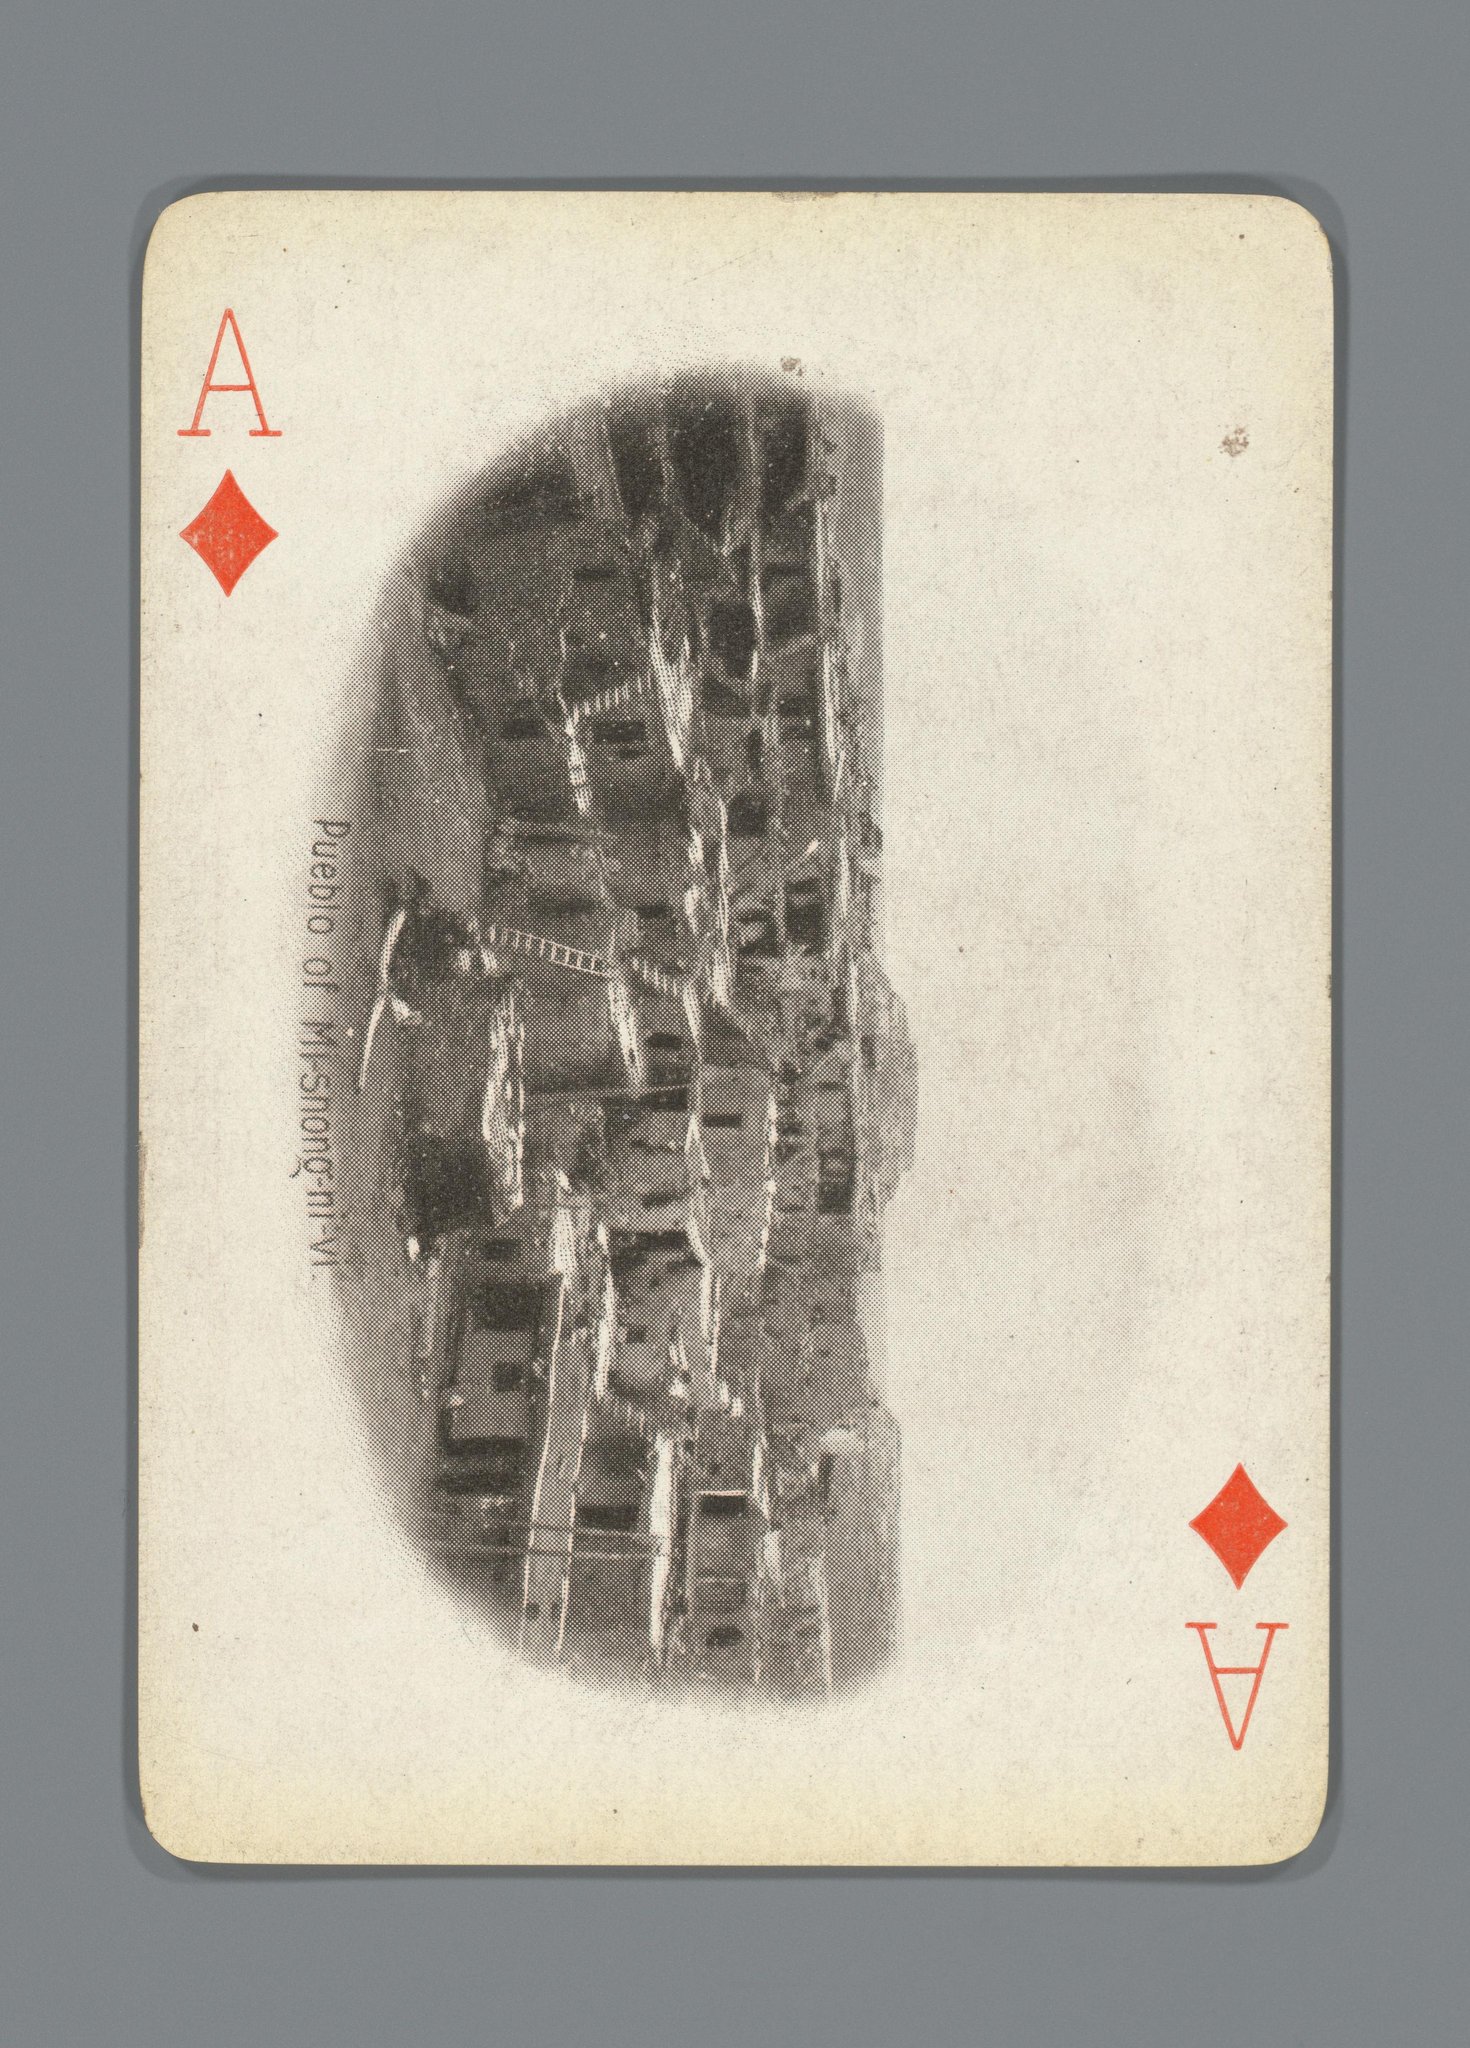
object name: photograph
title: Ruiten aas met gezicht op Musungnuvi (Mishongnovi), Second Mesa, Hopi Reservaat, Navajo County, Arizona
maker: adam clark vroman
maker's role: fotograaf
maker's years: 1856-1916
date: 1900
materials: paper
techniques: autotype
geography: united states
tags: arizona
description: Speelkaart uit doosje met 53 speelkaarten met afbeeldingen in autotypie van Native Americans. De inhoud bevat een complete set speelkaarten inclusief joker.